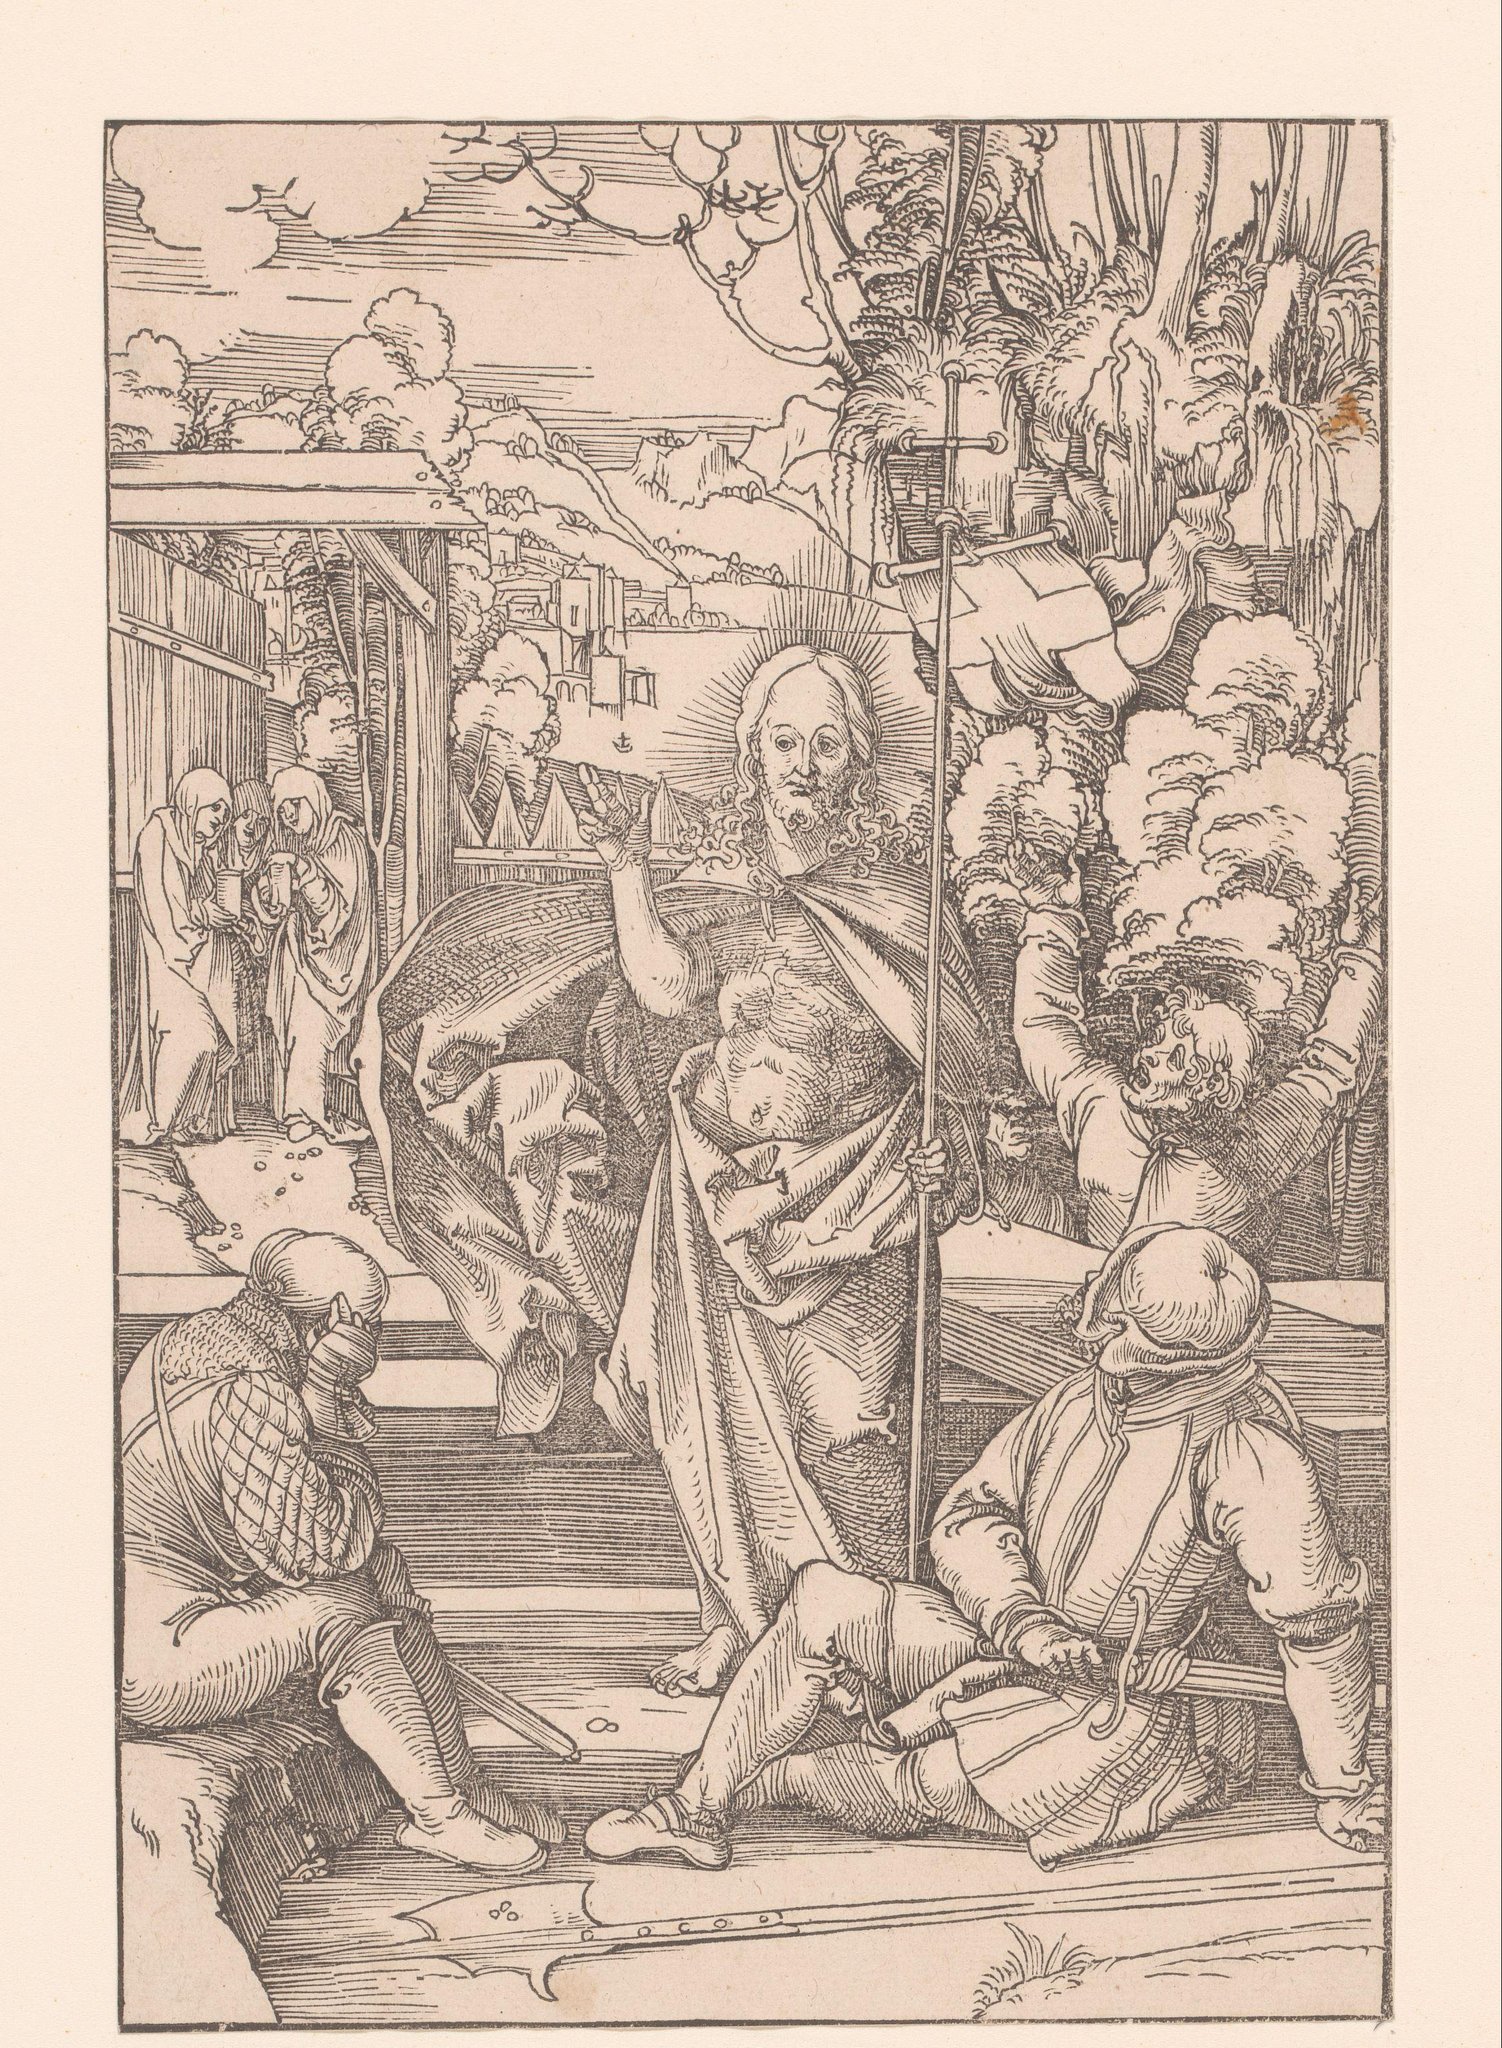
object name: book illustration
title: Opstanding van Christus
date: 1506-1507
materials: paper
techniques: woodcut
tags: christ, usually holding a banner, arises from the grave; often combined with sleeping and/or frightened soldiers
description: Prent voor het eerst gebruikt in: Speculum Passionis. Neurenberg: Ulrich Pinder, 1507.